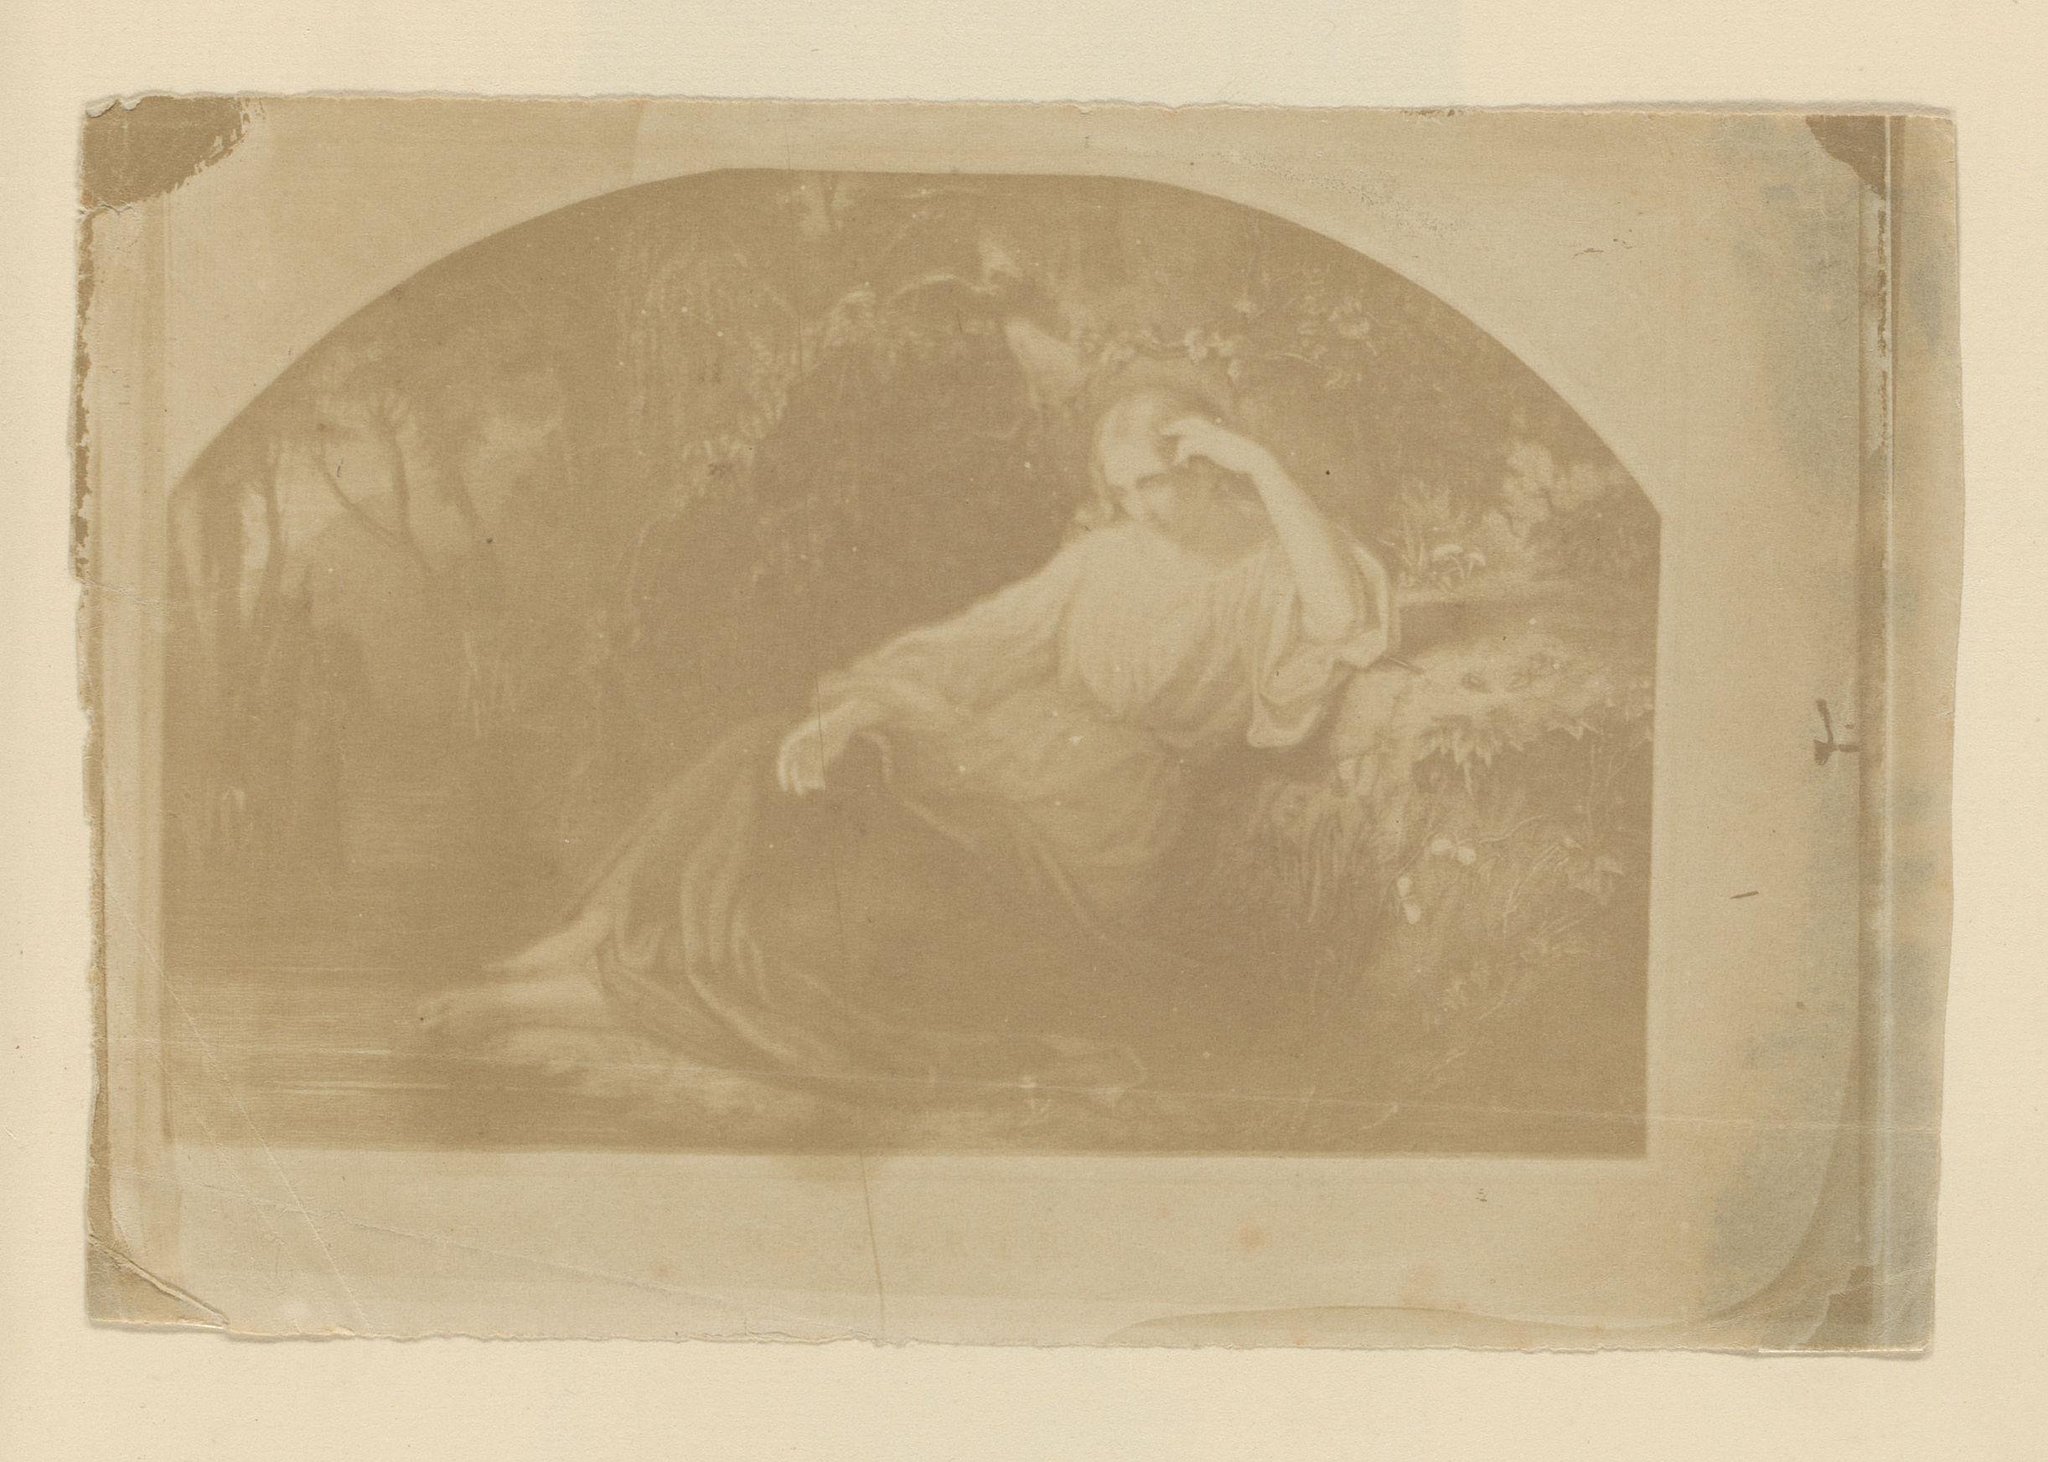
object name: photograph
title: Prent van C.E. Taurel naar het schilderij Mijmering van Jozef Israëls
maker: eduard isaac asser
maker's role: amateurfotograaf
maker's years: 1809-1894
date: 1855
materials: cardboard, paper, photographic support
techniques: salted paper print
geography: amsterdam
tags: art